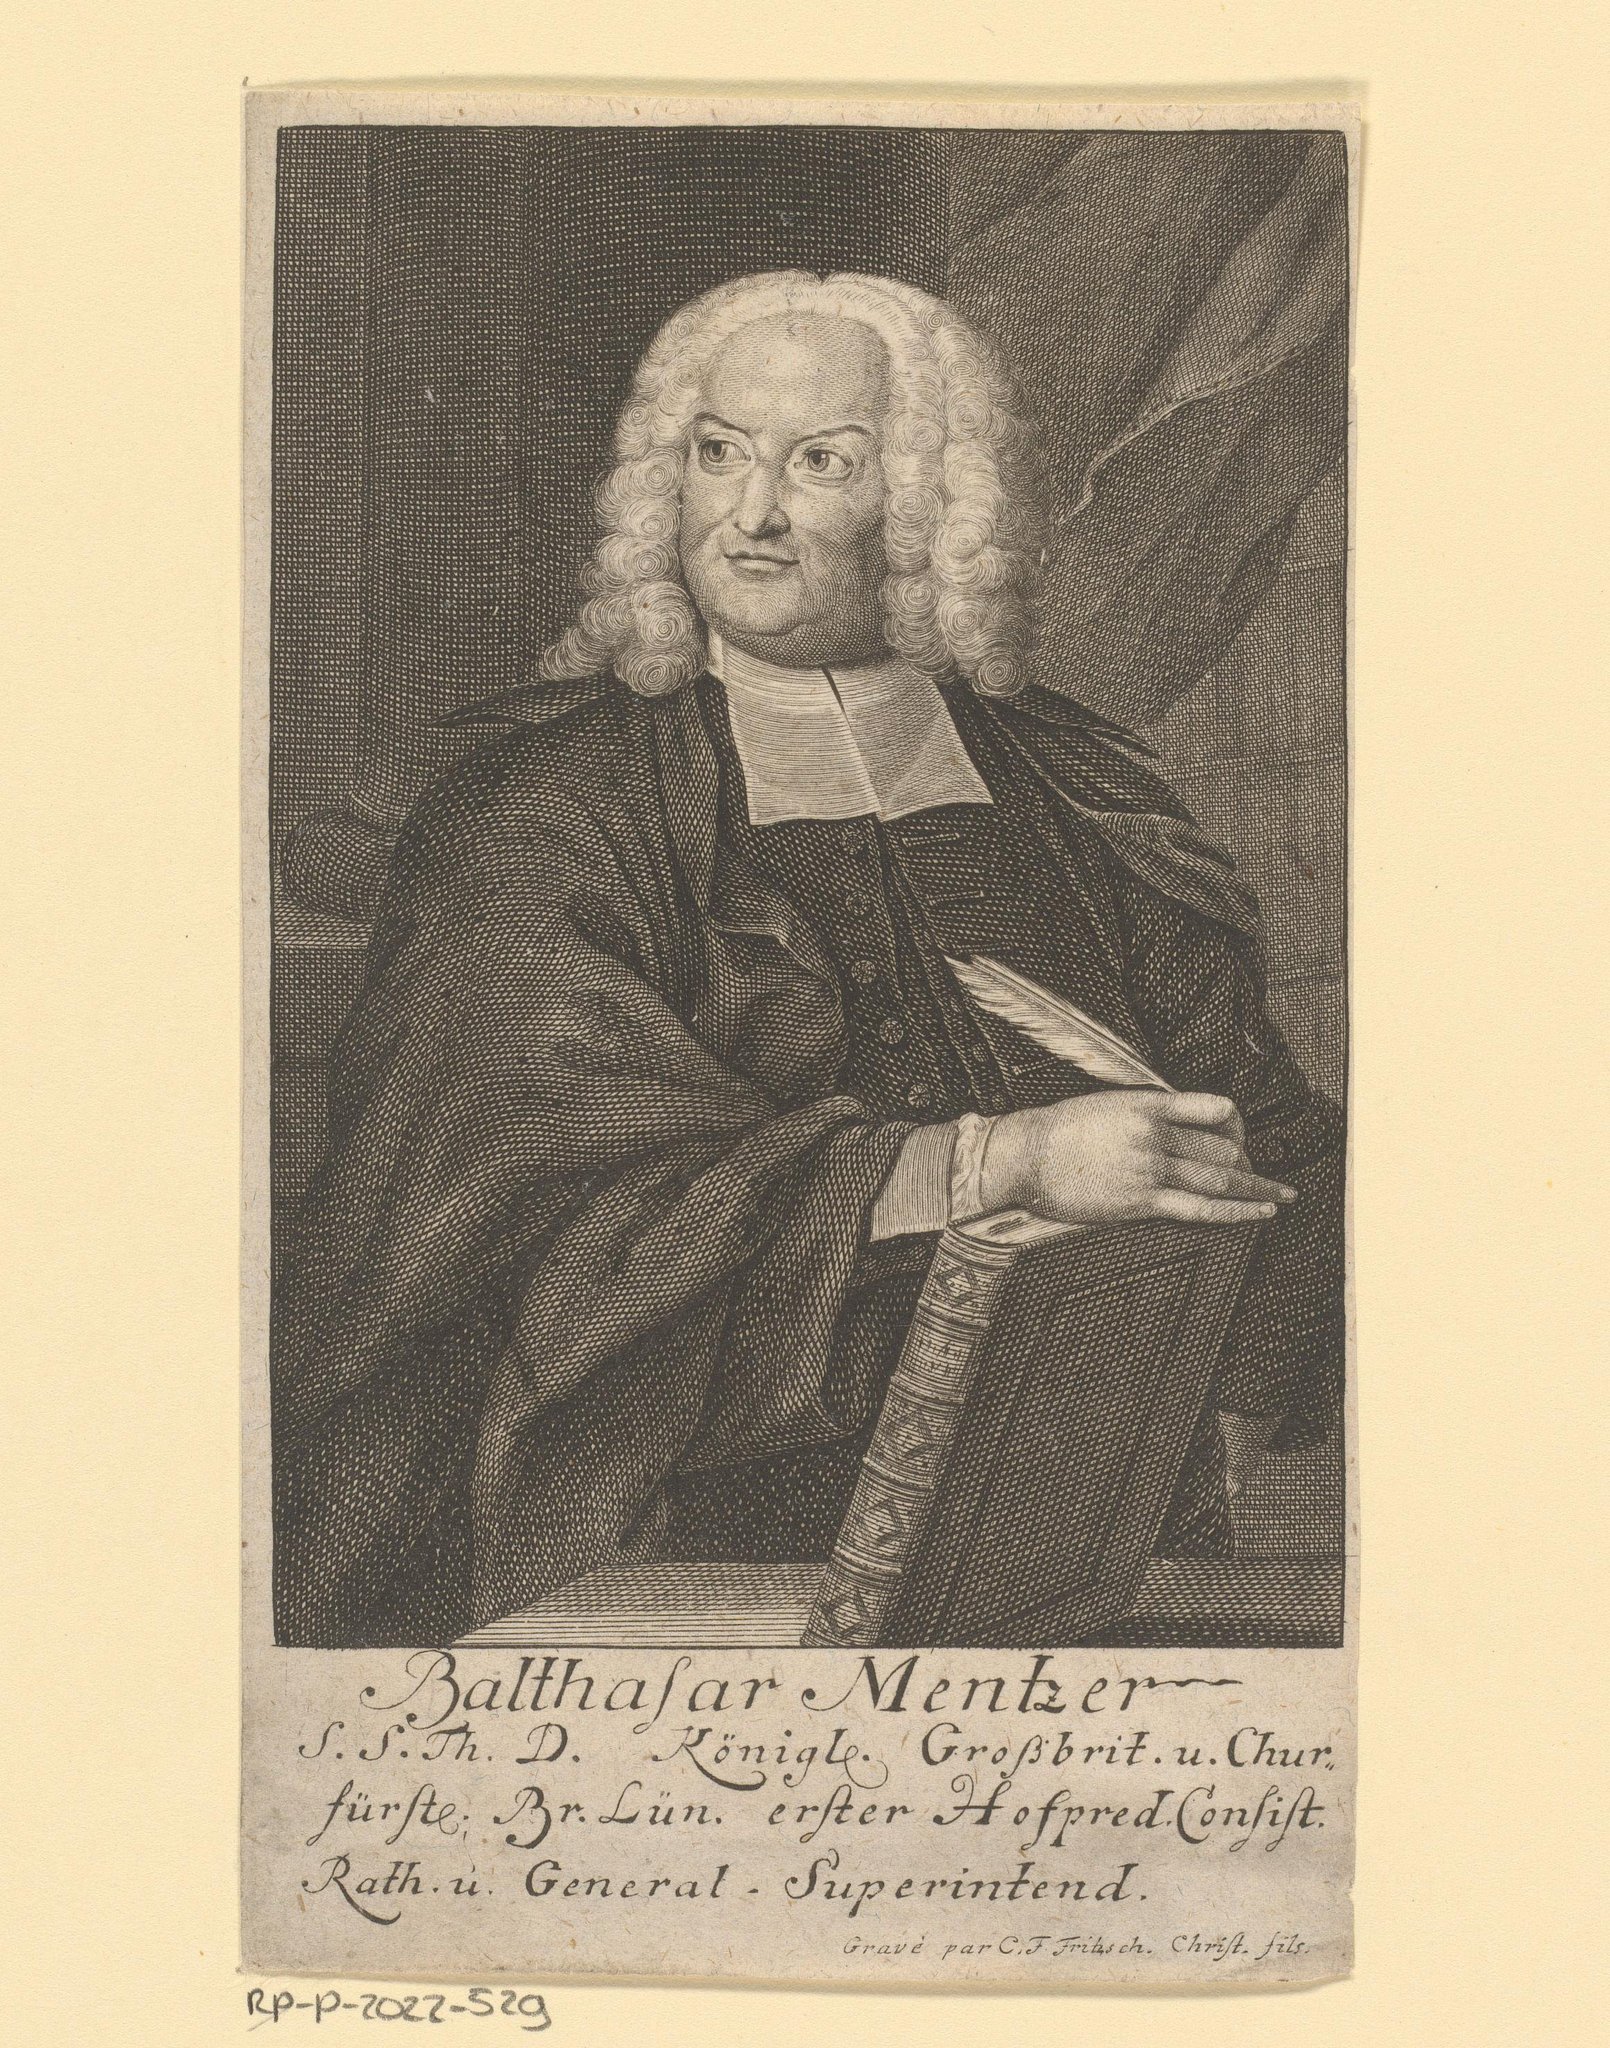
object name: print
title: Balthasar Mentzer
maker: christian friedrich fritzsch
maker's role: print maker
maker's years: 1719-1774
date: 1729-1774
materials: paper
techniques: engraving, etching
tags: balthasar mentzer, historical persons